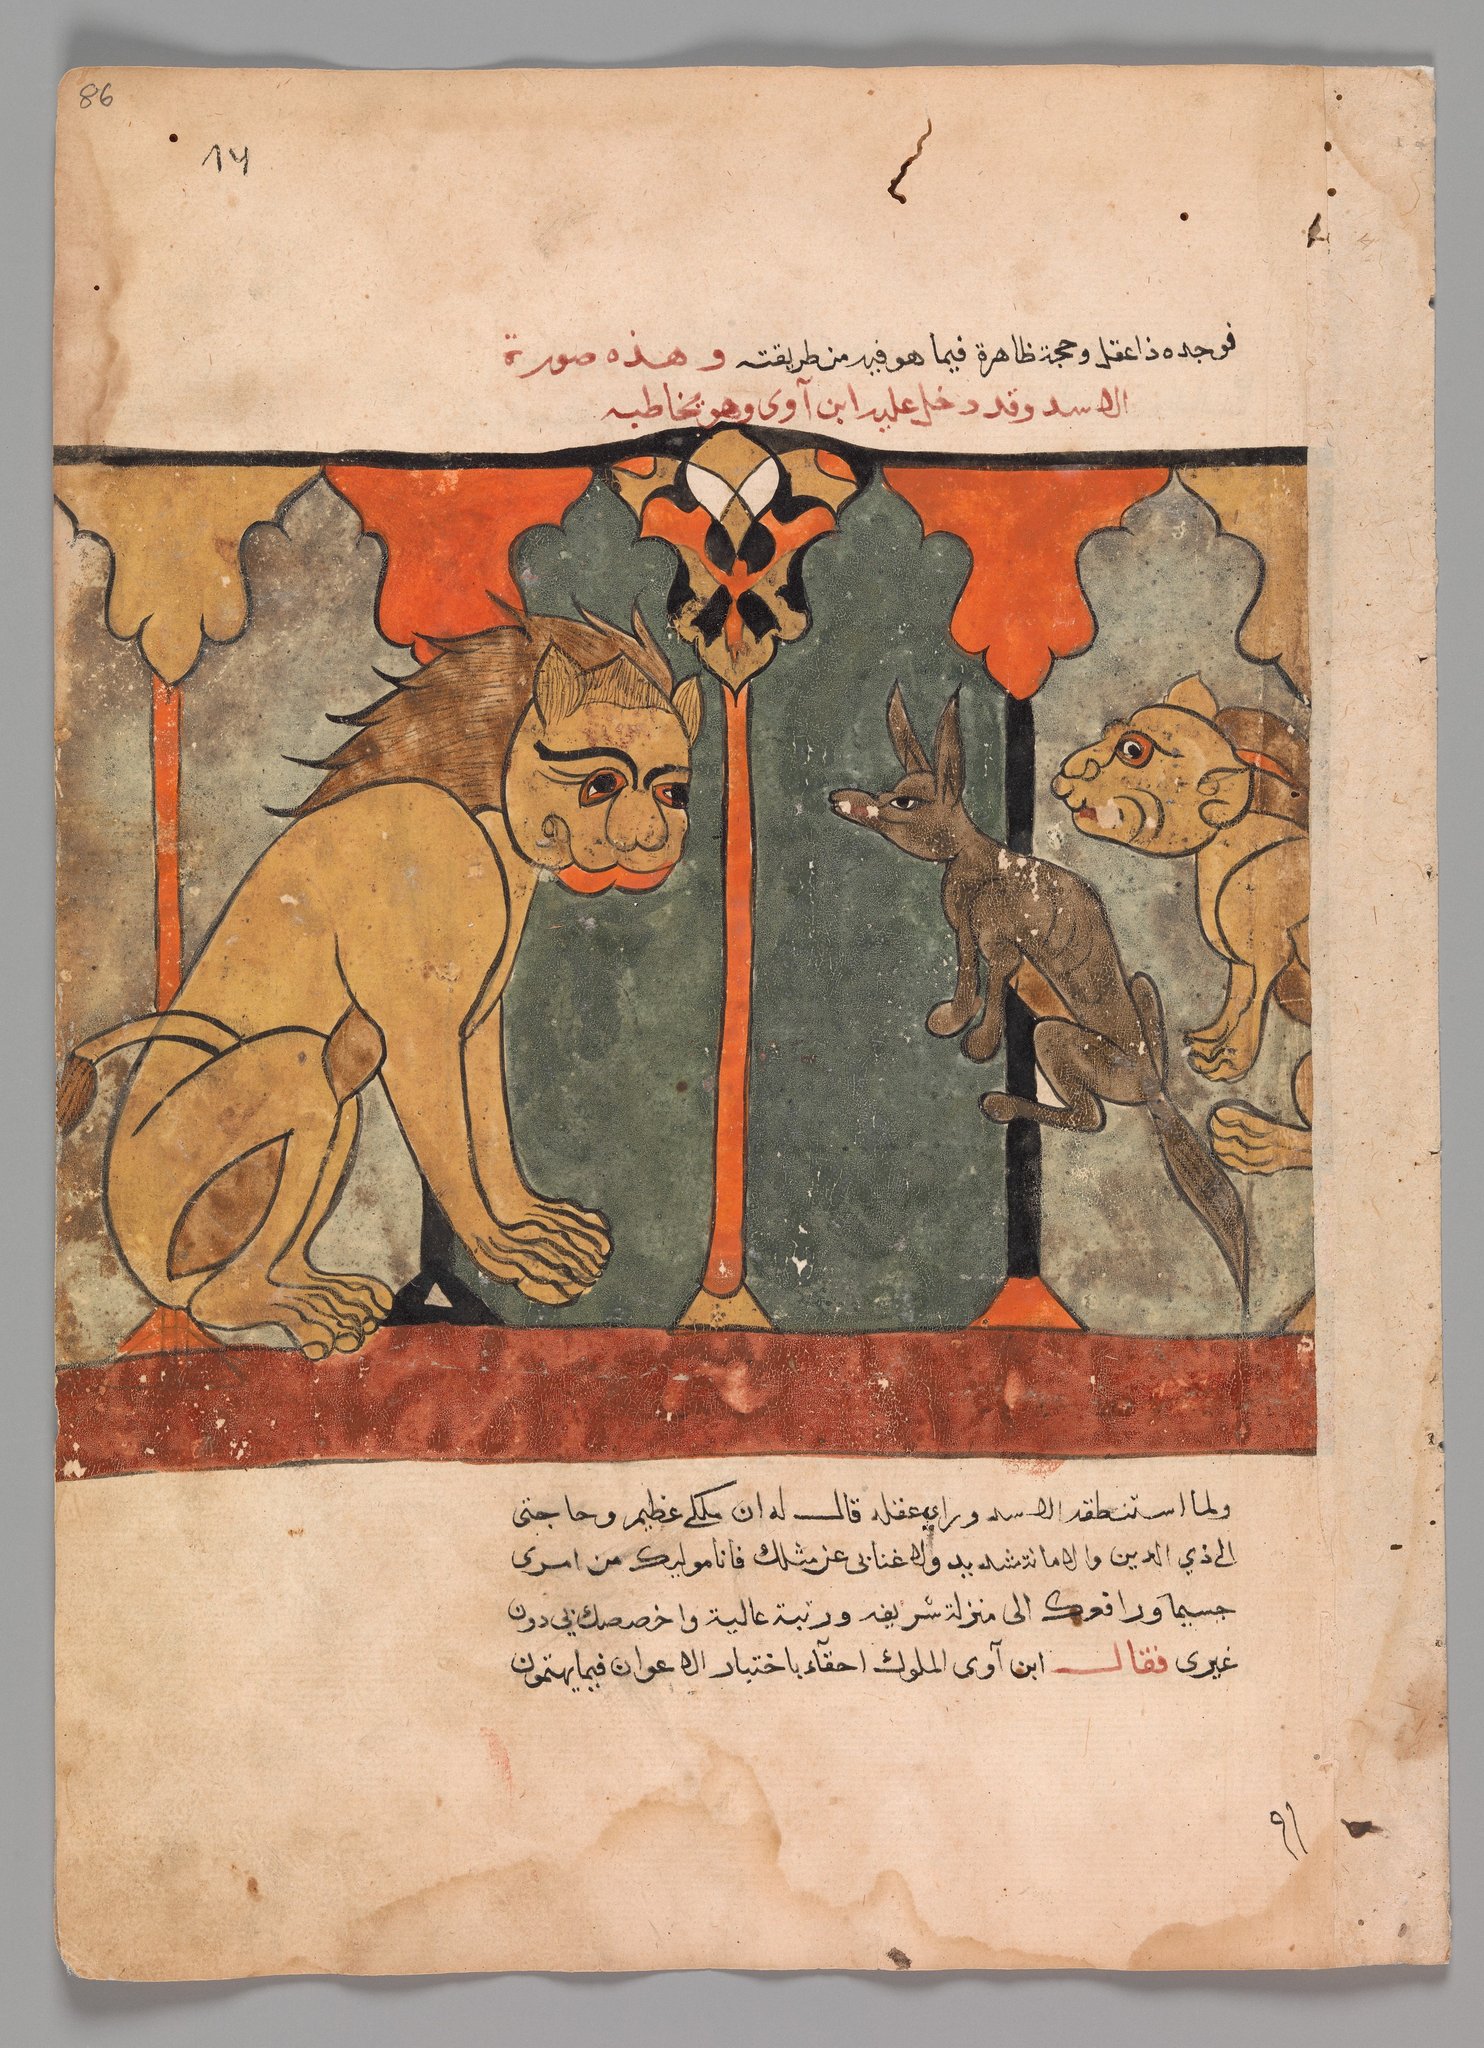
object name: folio from an illustrated manuscript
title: "The Lion-King Recruits the Ascetic Jackal", Folio from a Kalila wa Dimna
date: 1526-1550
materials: ink, paper, watercolor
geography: india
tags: lions